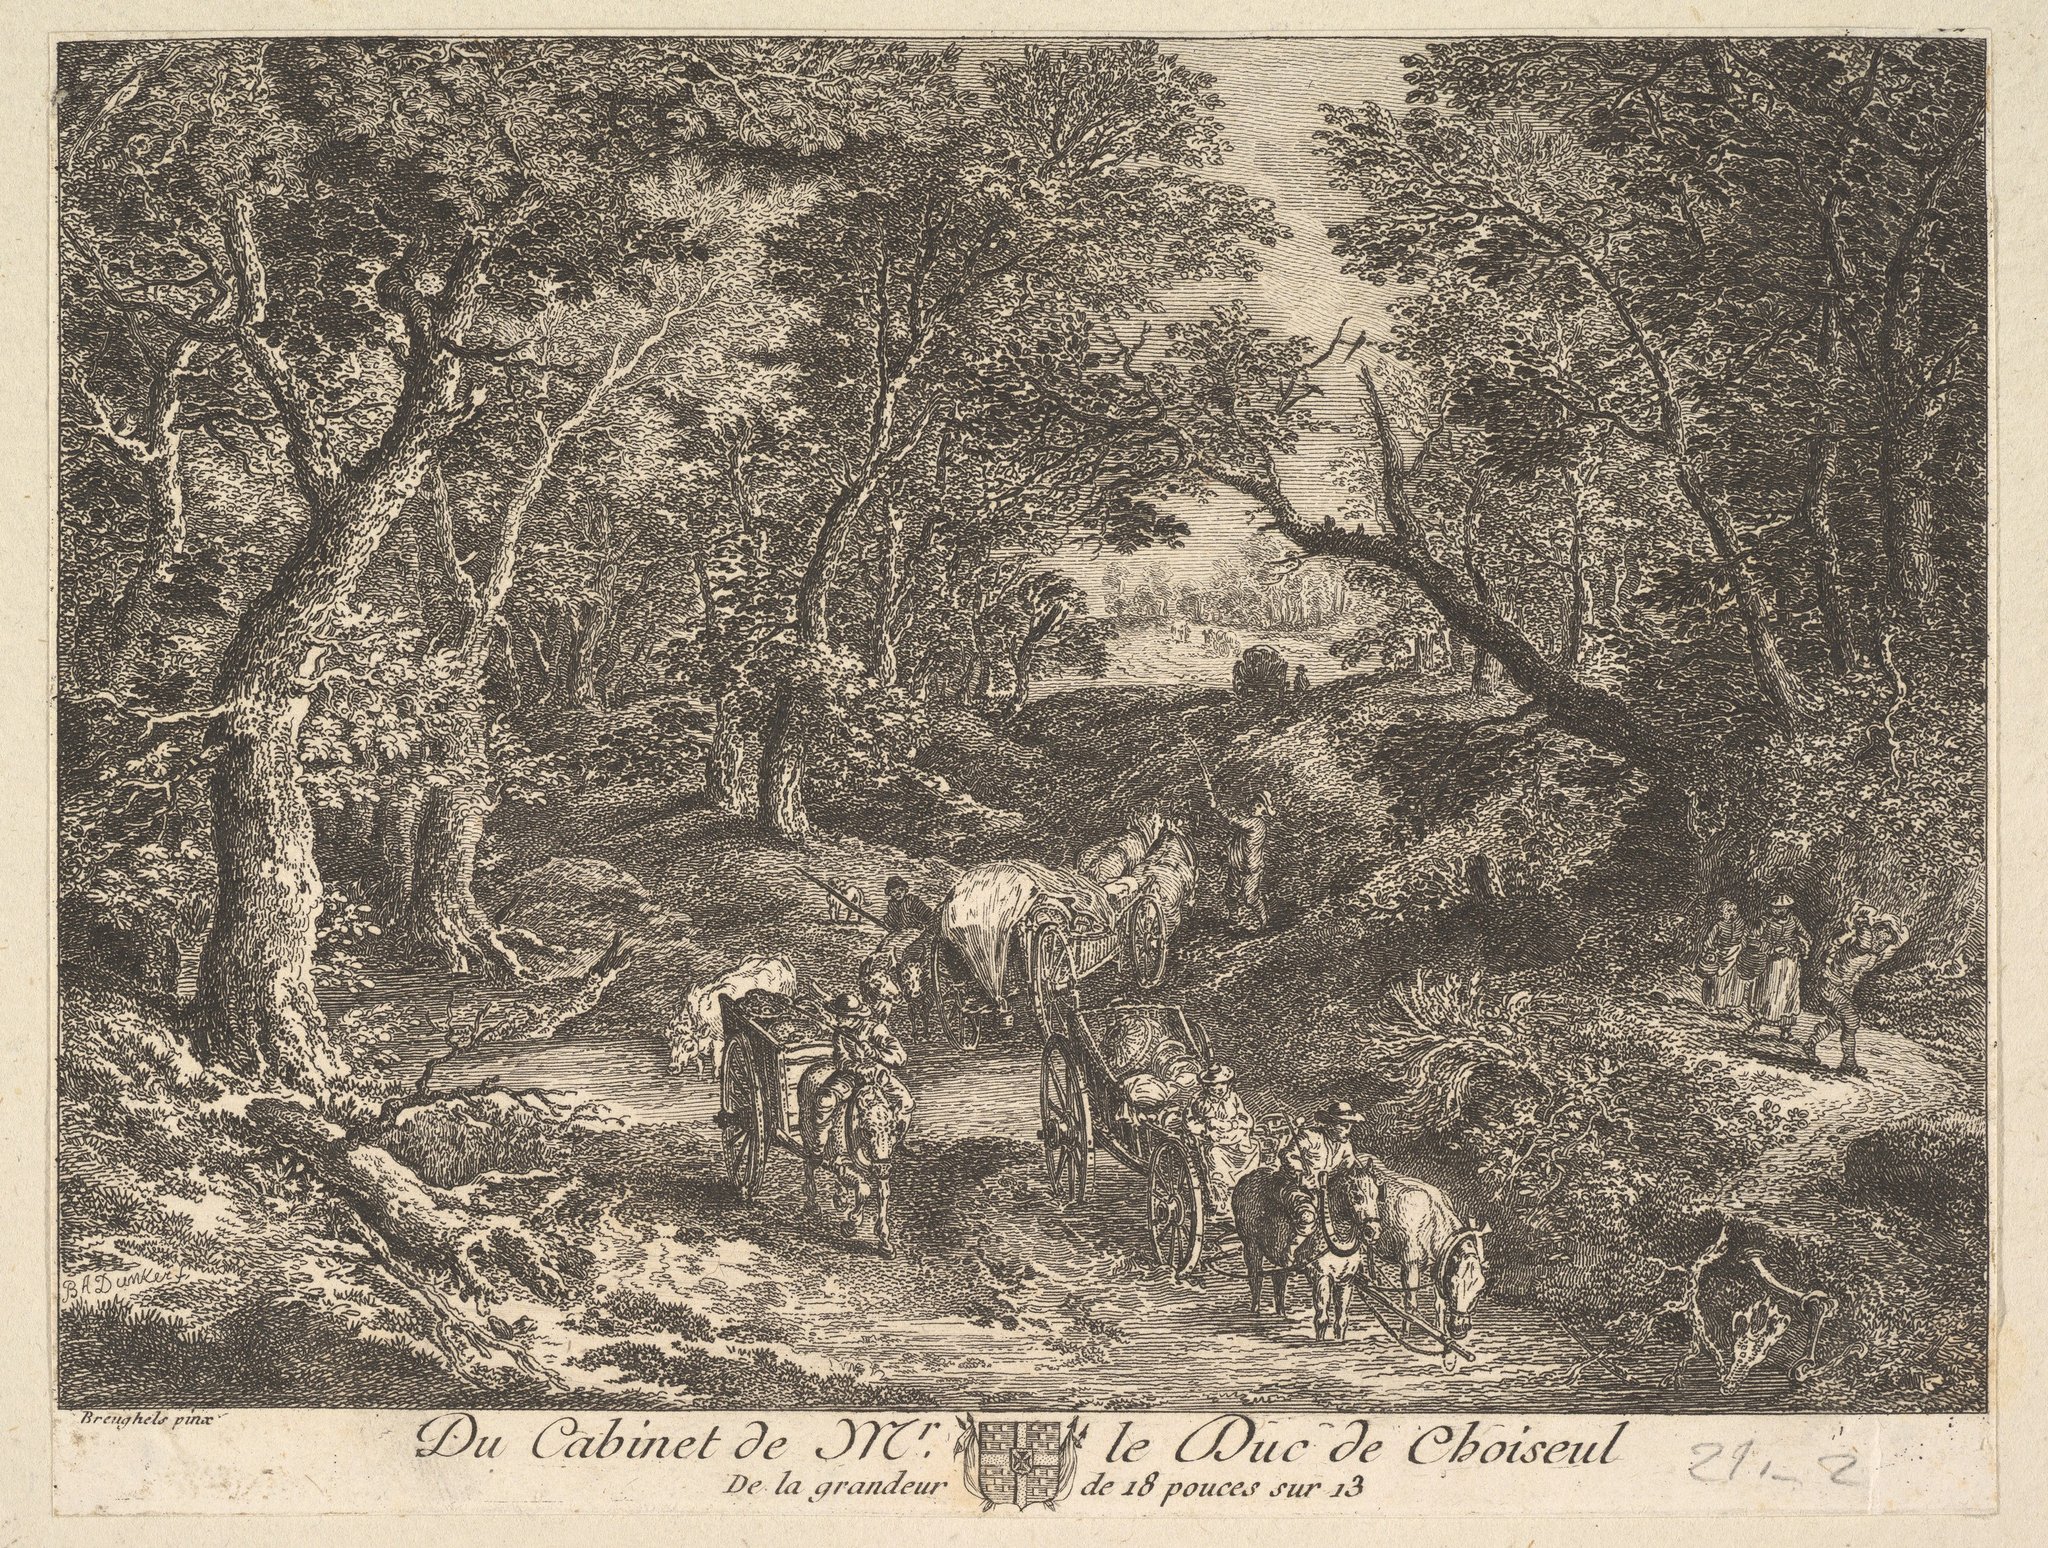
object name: print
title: Carts on a Path through the Woods after a painting in the collection of the Duc de Choiseul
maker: anonymous, french, 18th century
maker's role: artist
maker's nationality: french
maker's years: 1700-1800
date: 1771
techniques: engraving, etching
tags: human figures,roads,horses,trees,carriages